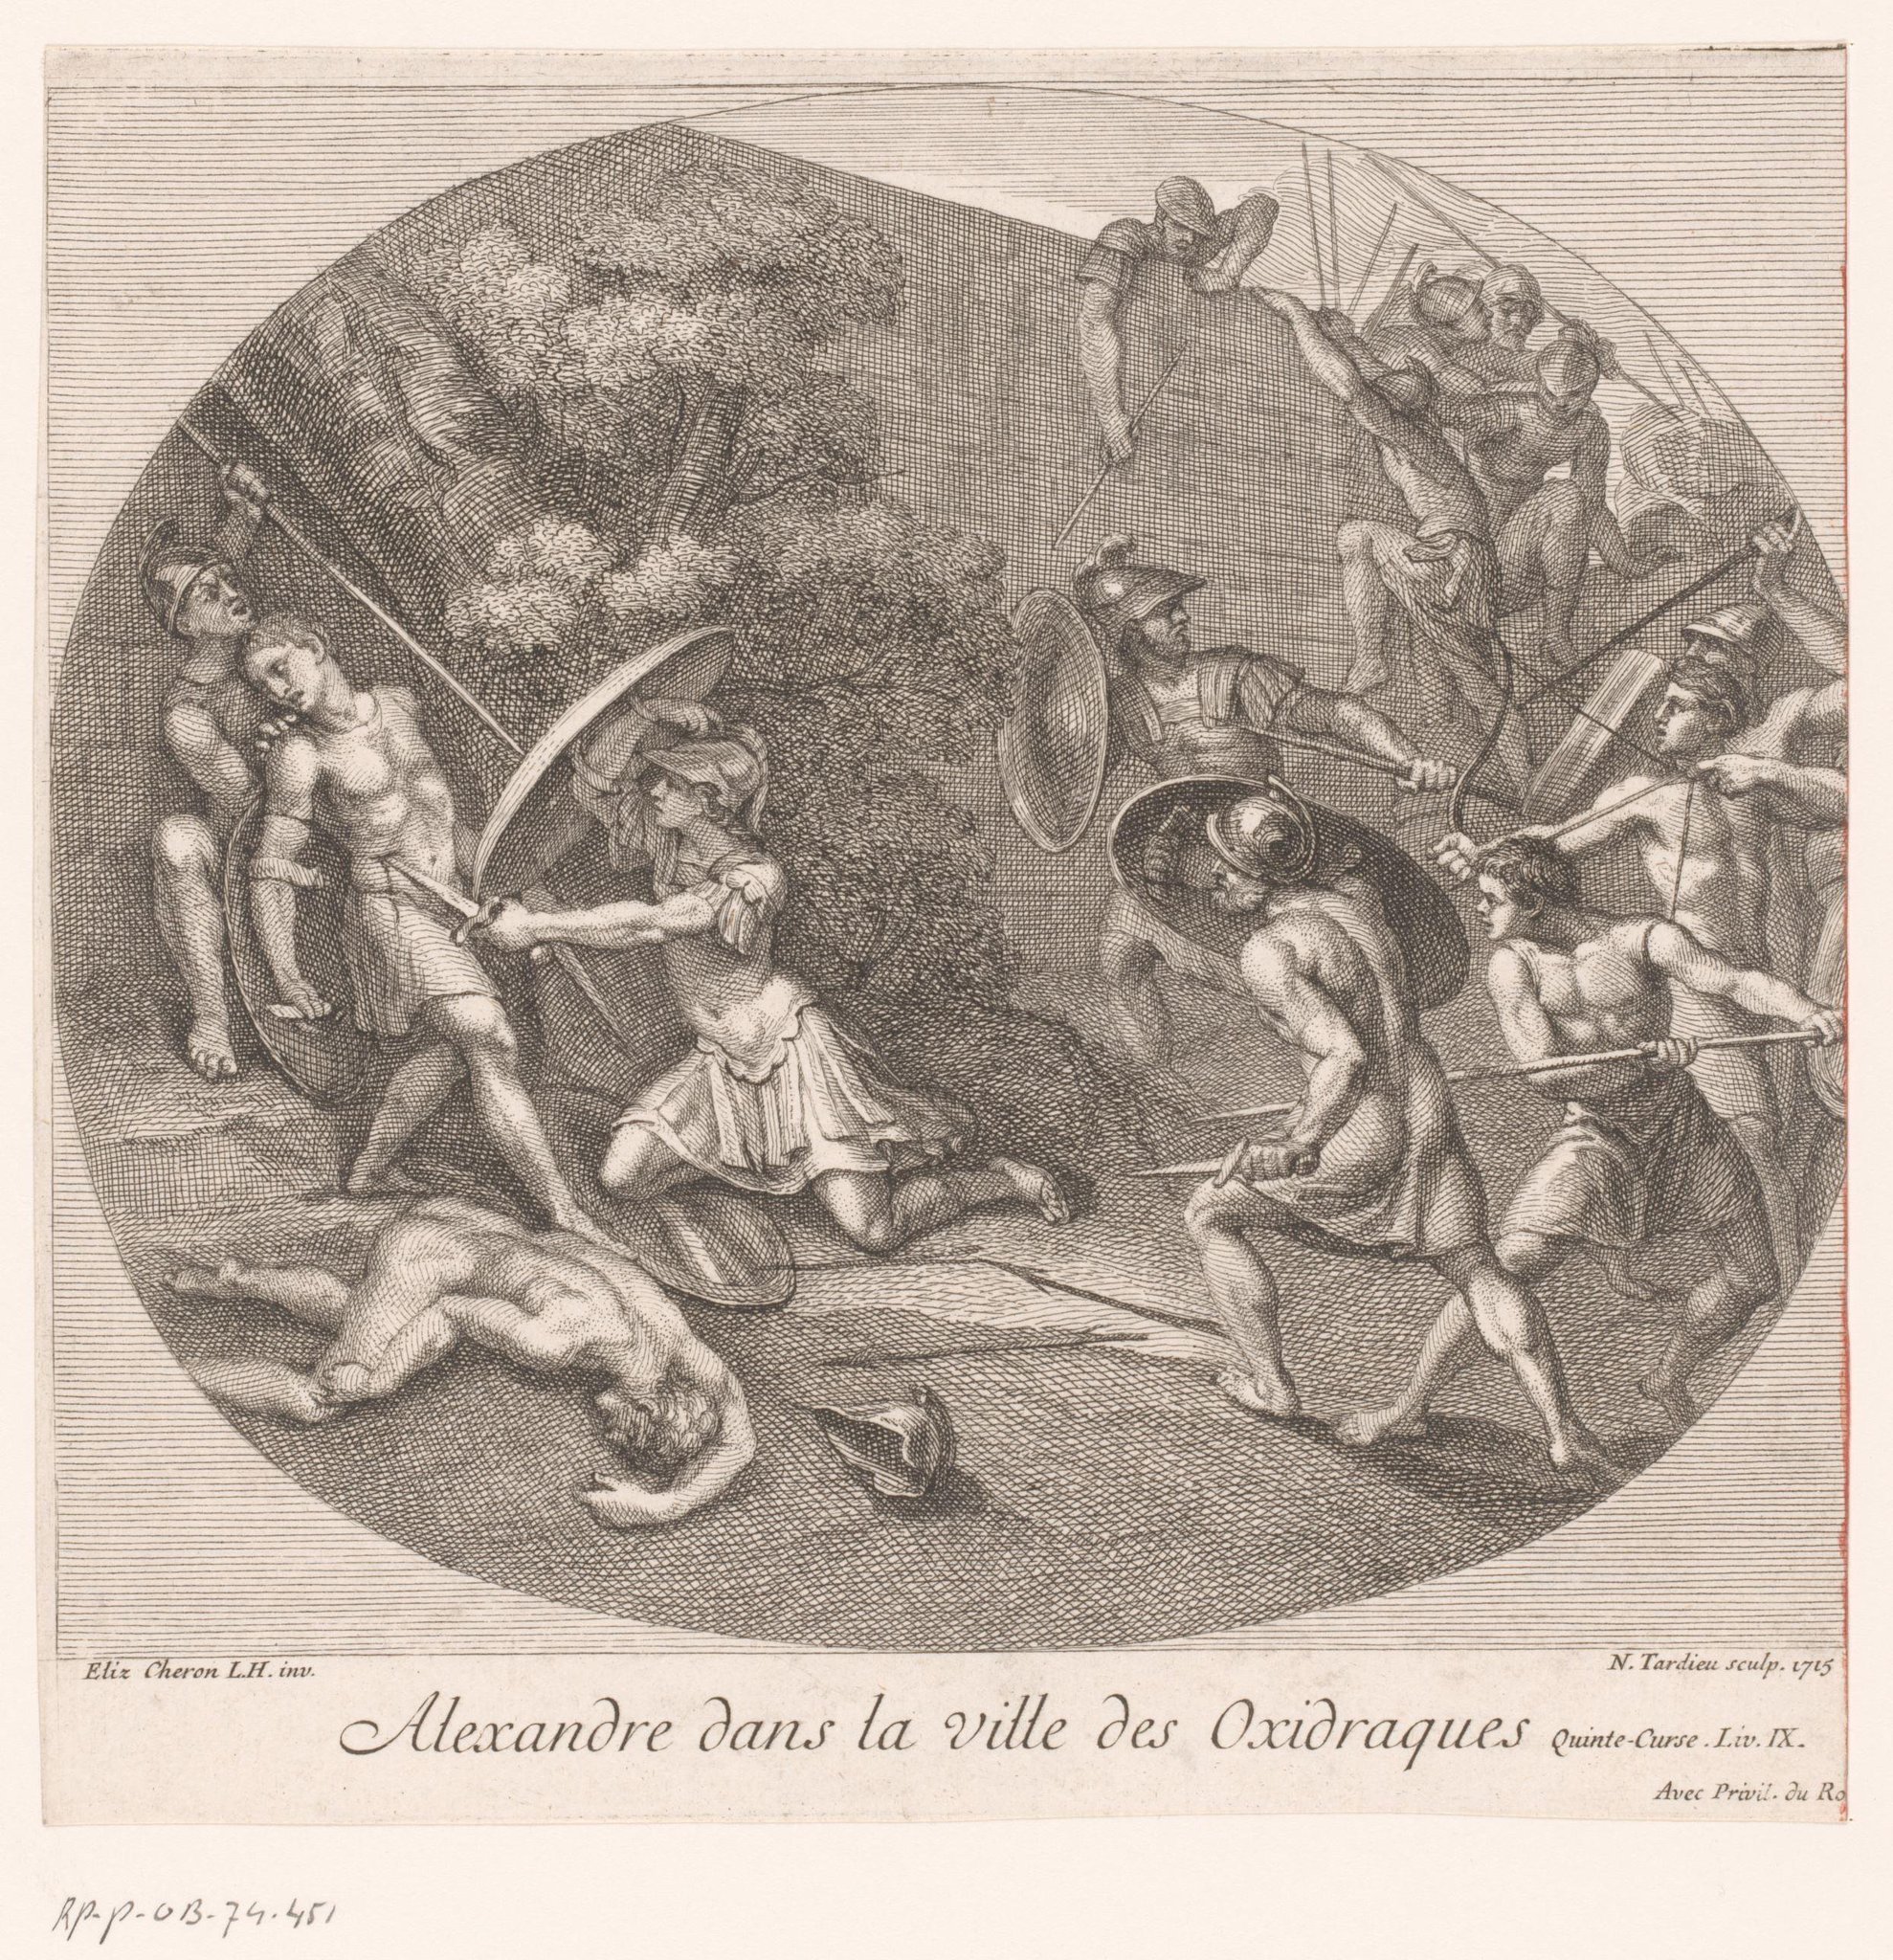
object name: print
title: Alexander de Grote in een veldslag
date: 1715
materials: paper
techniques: engraving, etching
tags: battles of alexander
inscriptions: date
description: Prent gebruikt voor een uitgave van: Quinte-Curce. De la vie & des actions d'Alexandre le Grand.